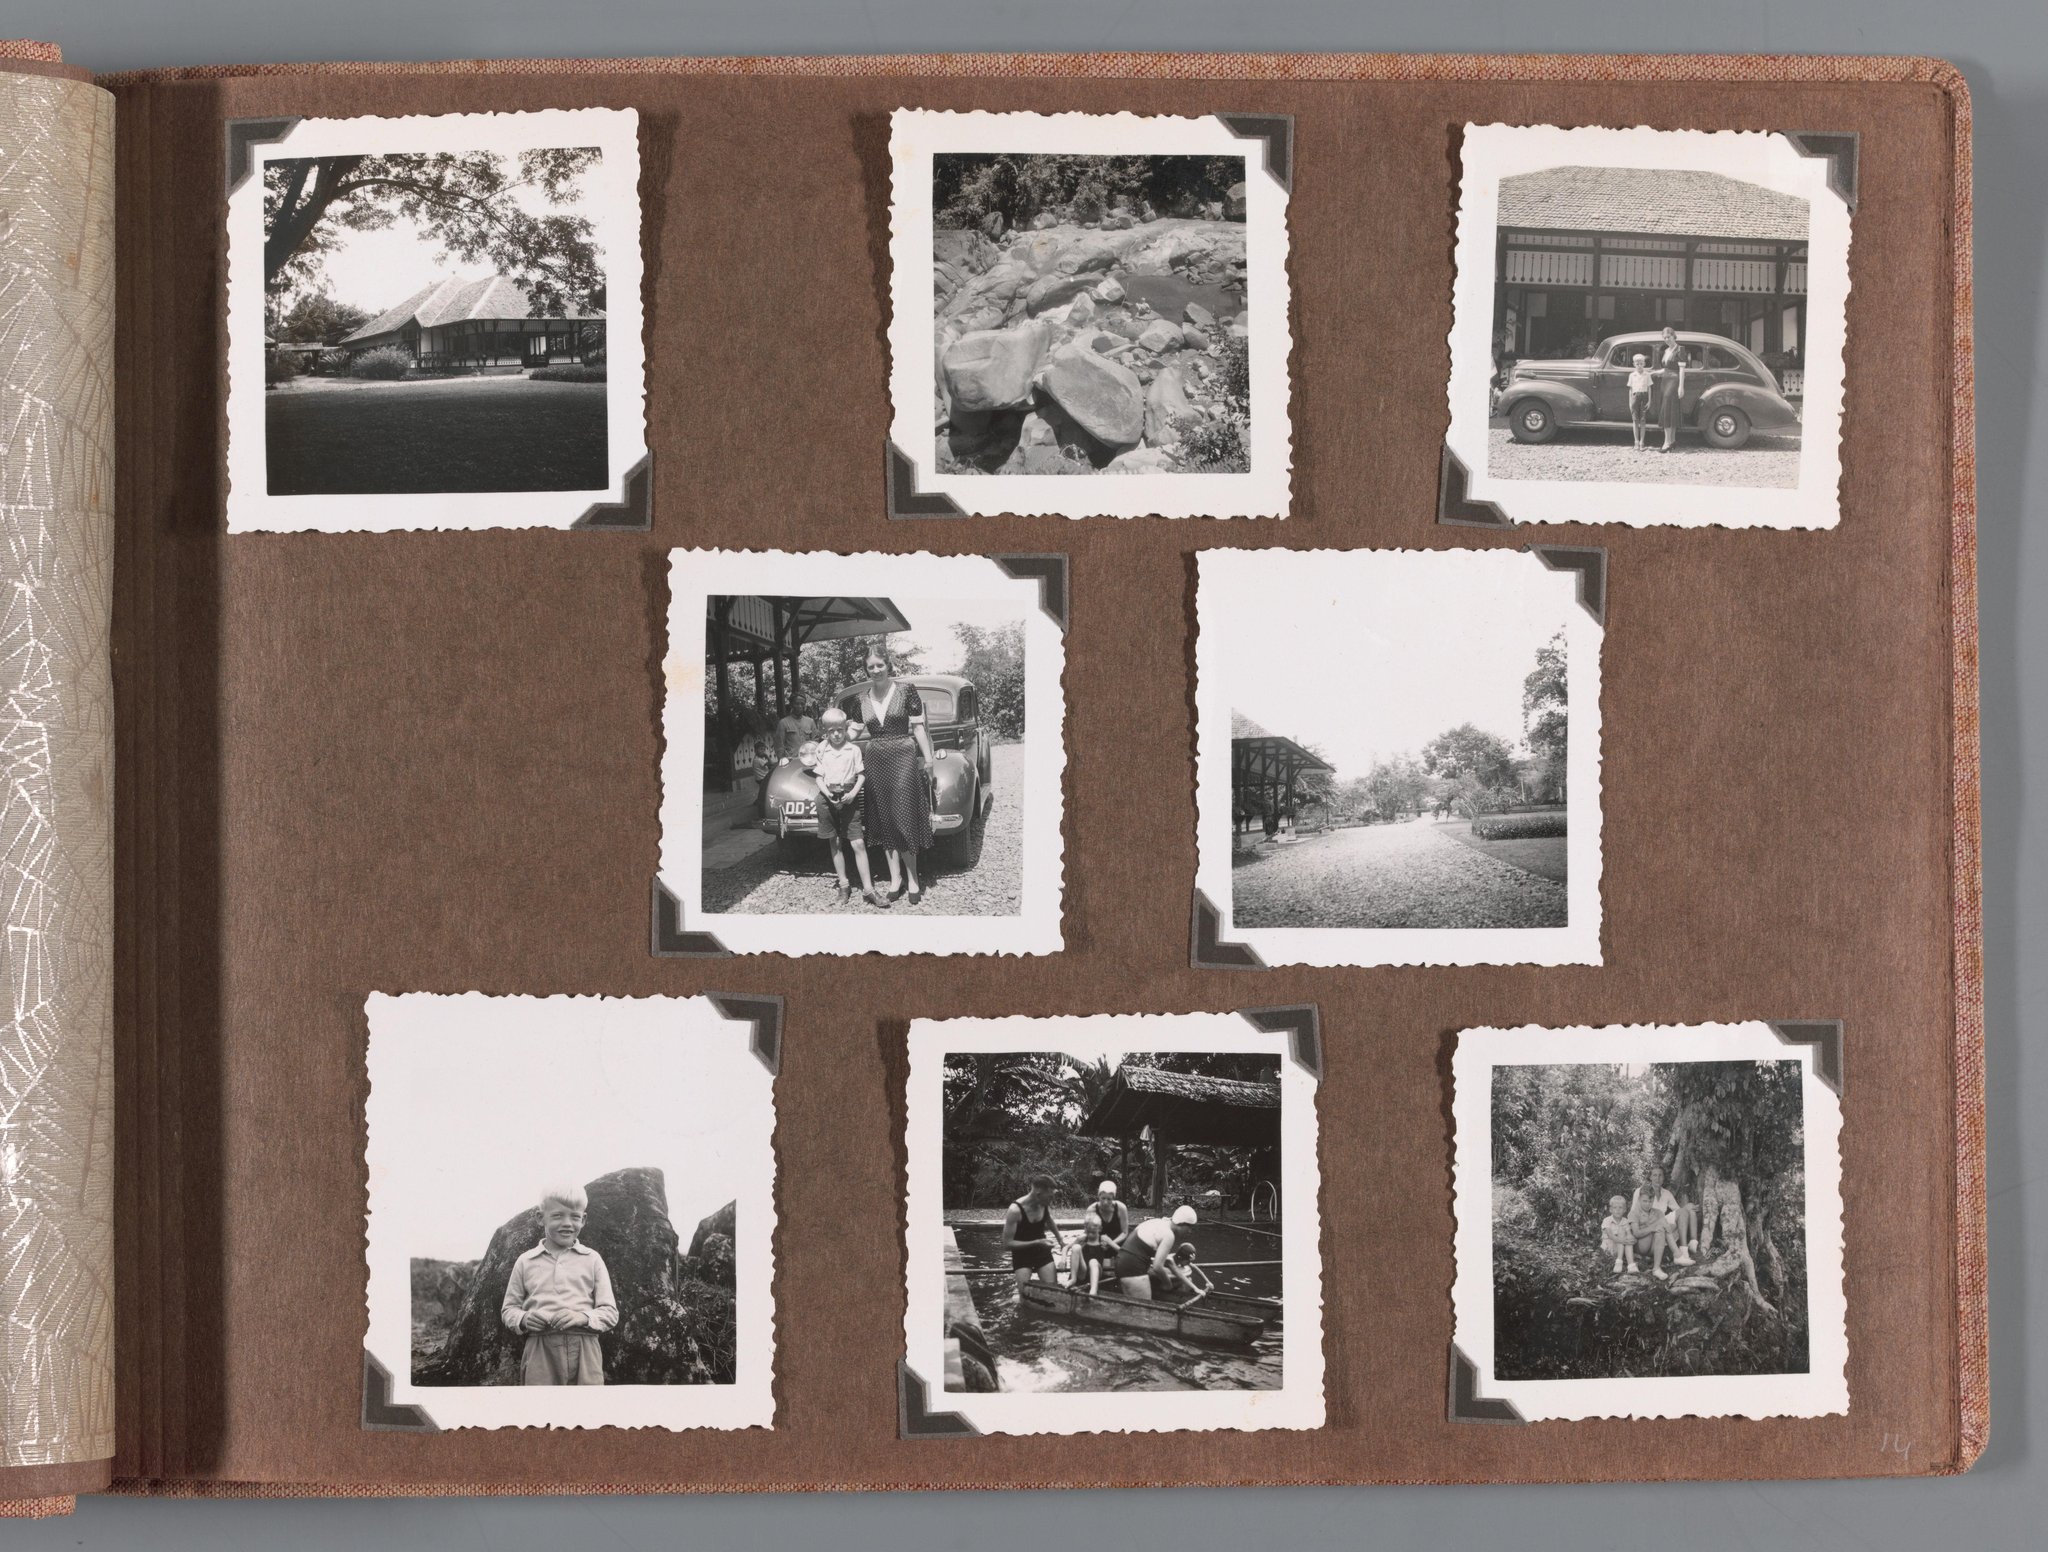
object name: album leaf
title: Familefoto's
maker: Anonymous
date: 1939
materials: cardboard, photographic support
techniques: gelatin silver print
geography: celebes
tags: r.h. vonk, family life, villa, outing, pleasure trip, automobile, coast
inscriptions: inscription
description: Albumblad met acht foto's van de familie Vonk en vrienden, hun huis, auto en uitstapjes, 1939. Onderdeel van het fotoalbum van familie Vonk op Zuid-Celebes.